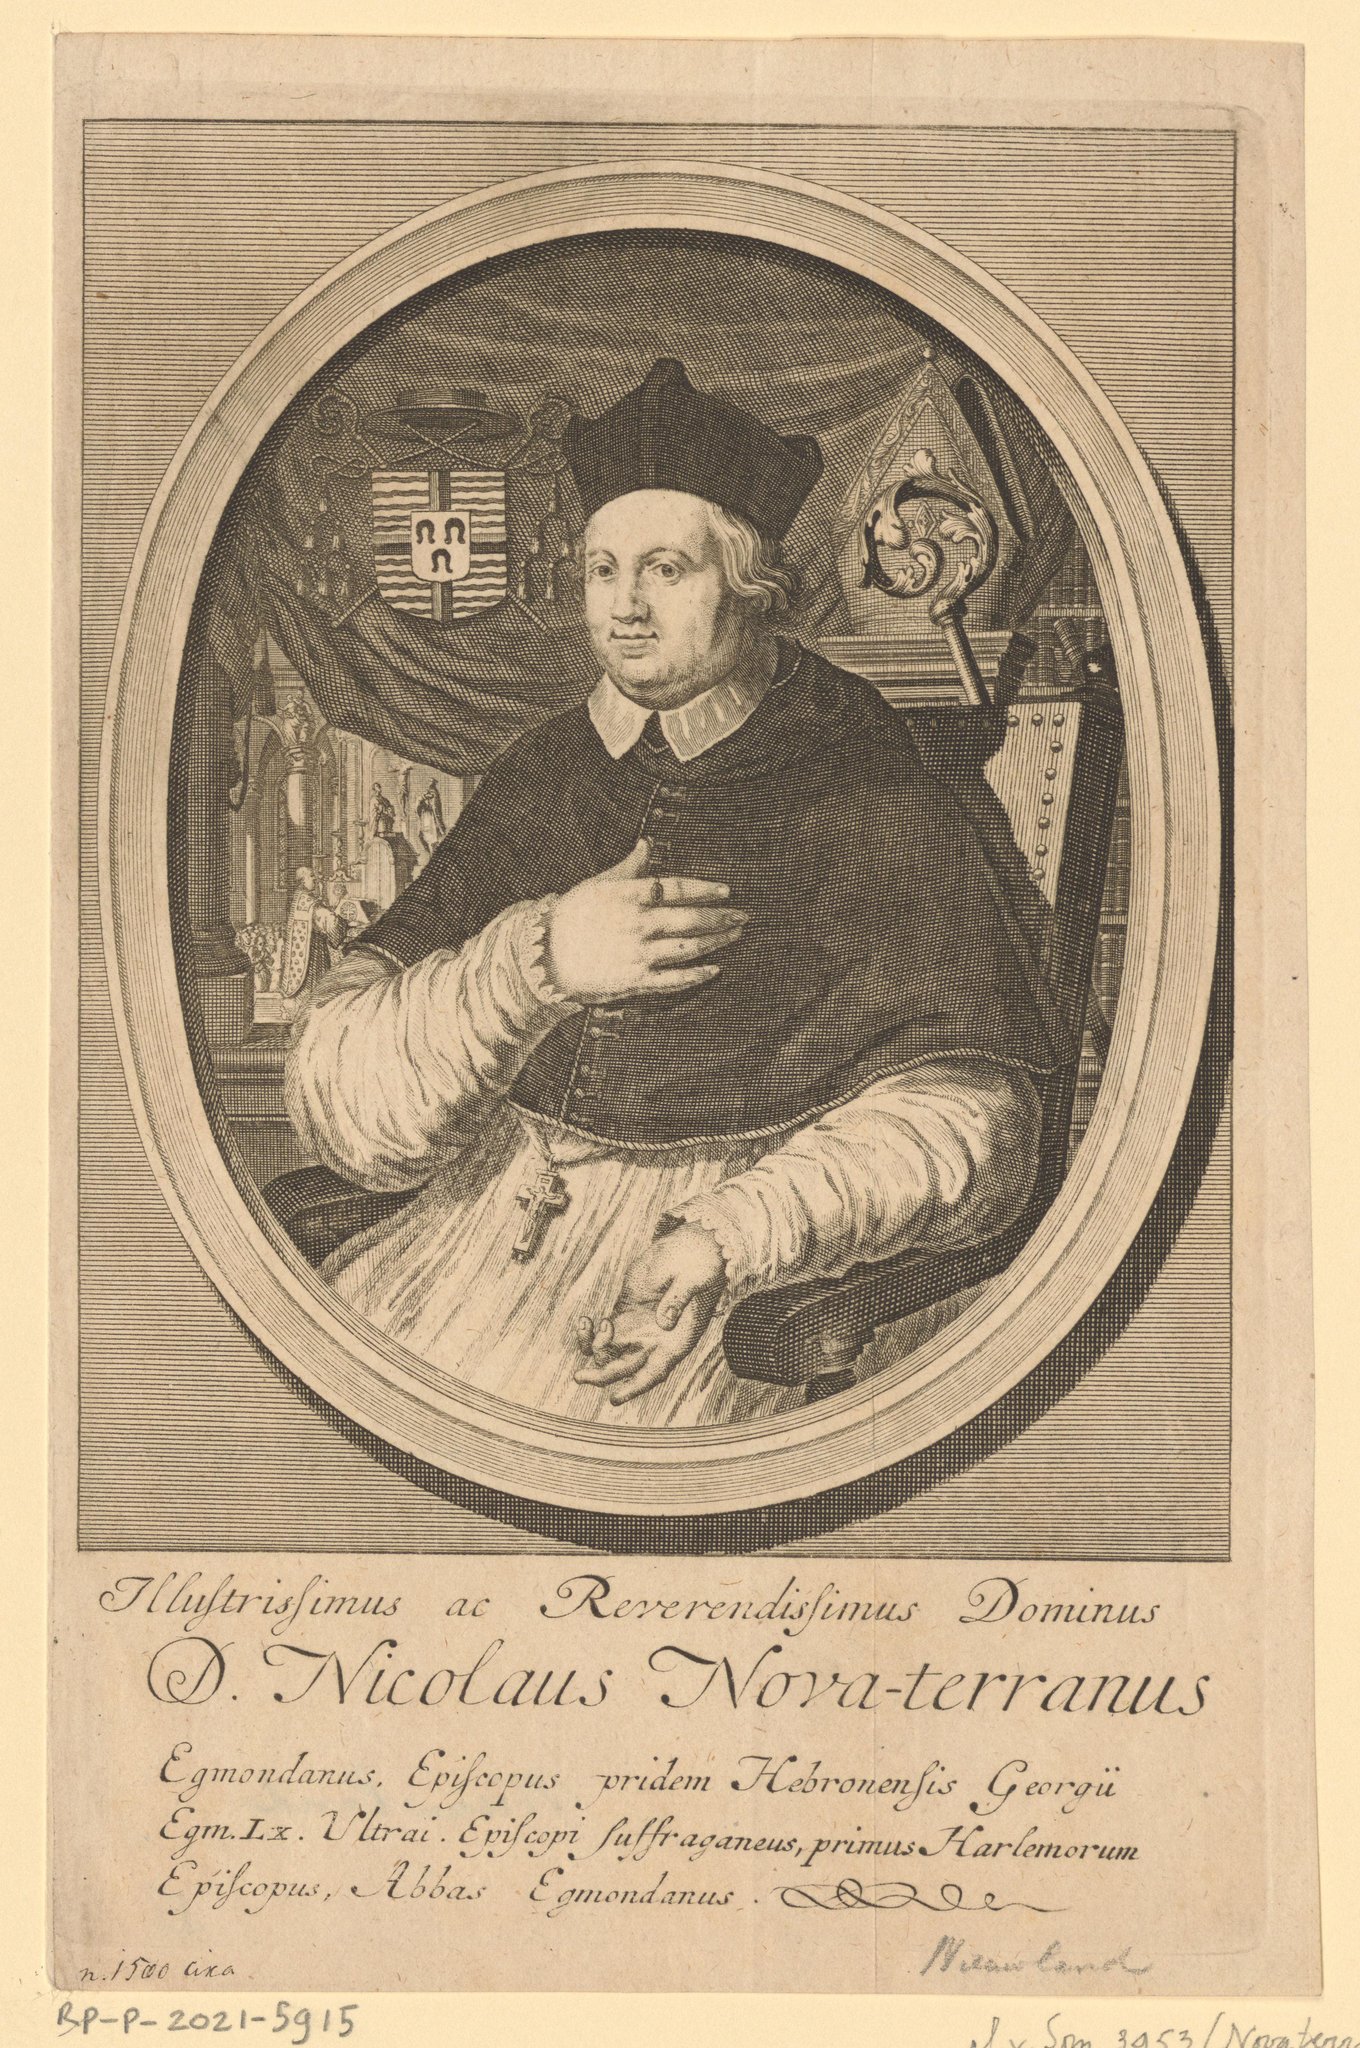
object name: print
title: Portret van Nicolaas van Nieuwland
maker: Anonymous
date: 1719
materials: paper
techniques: engraving, etching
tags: utrecht, archbishop, bishop, etc. (roman catholic), historical persons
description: Prent met tekst in boekdruk op verso gebruikt in: Heussen, Hugo Franciscus. Historia episcopatuum foederati Belgii (...). Leiden: Christiaan Vermey, 1719.